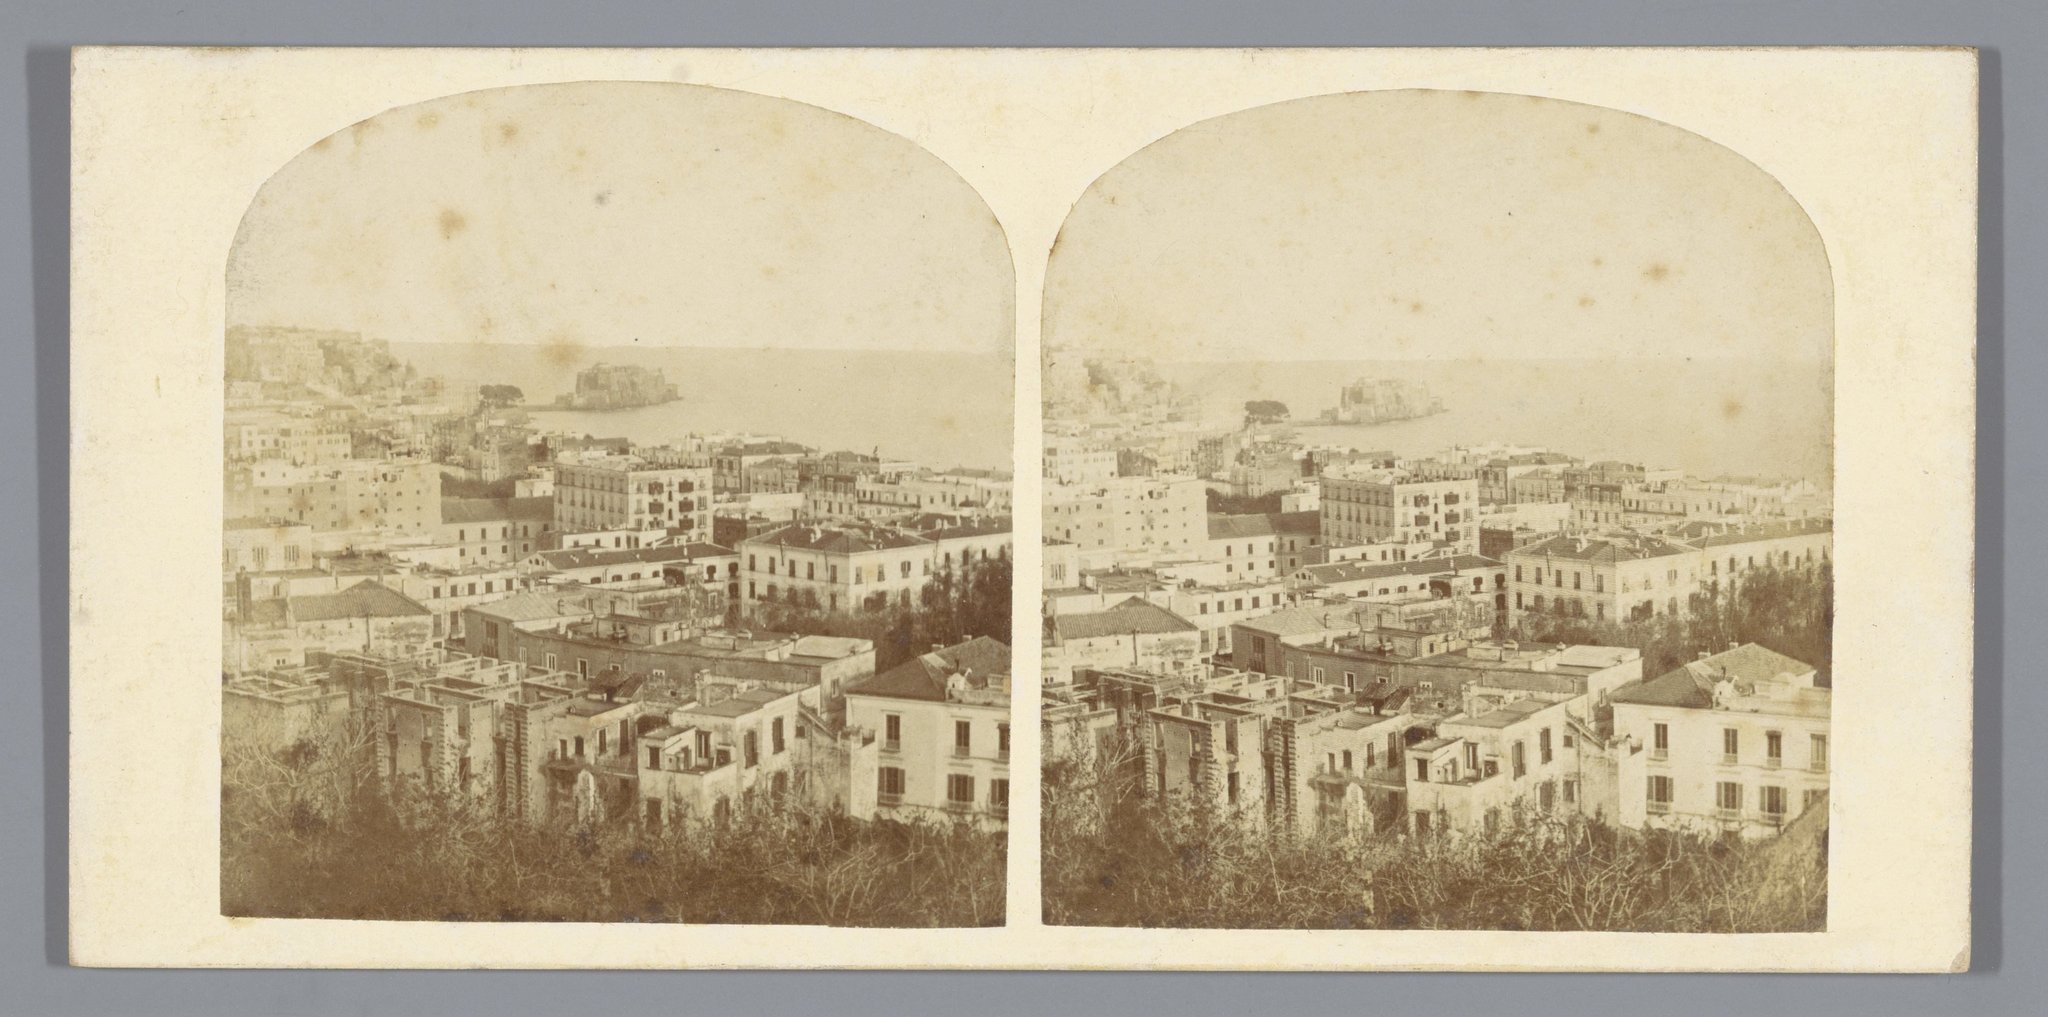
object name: stereograph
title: NAPLES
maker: Anonymous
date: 1850-1880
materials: cardboard, photographic support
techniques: albumen print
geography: naples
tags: city-view in general; 'veduta', naples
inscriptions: inscription: ‘Panorama’